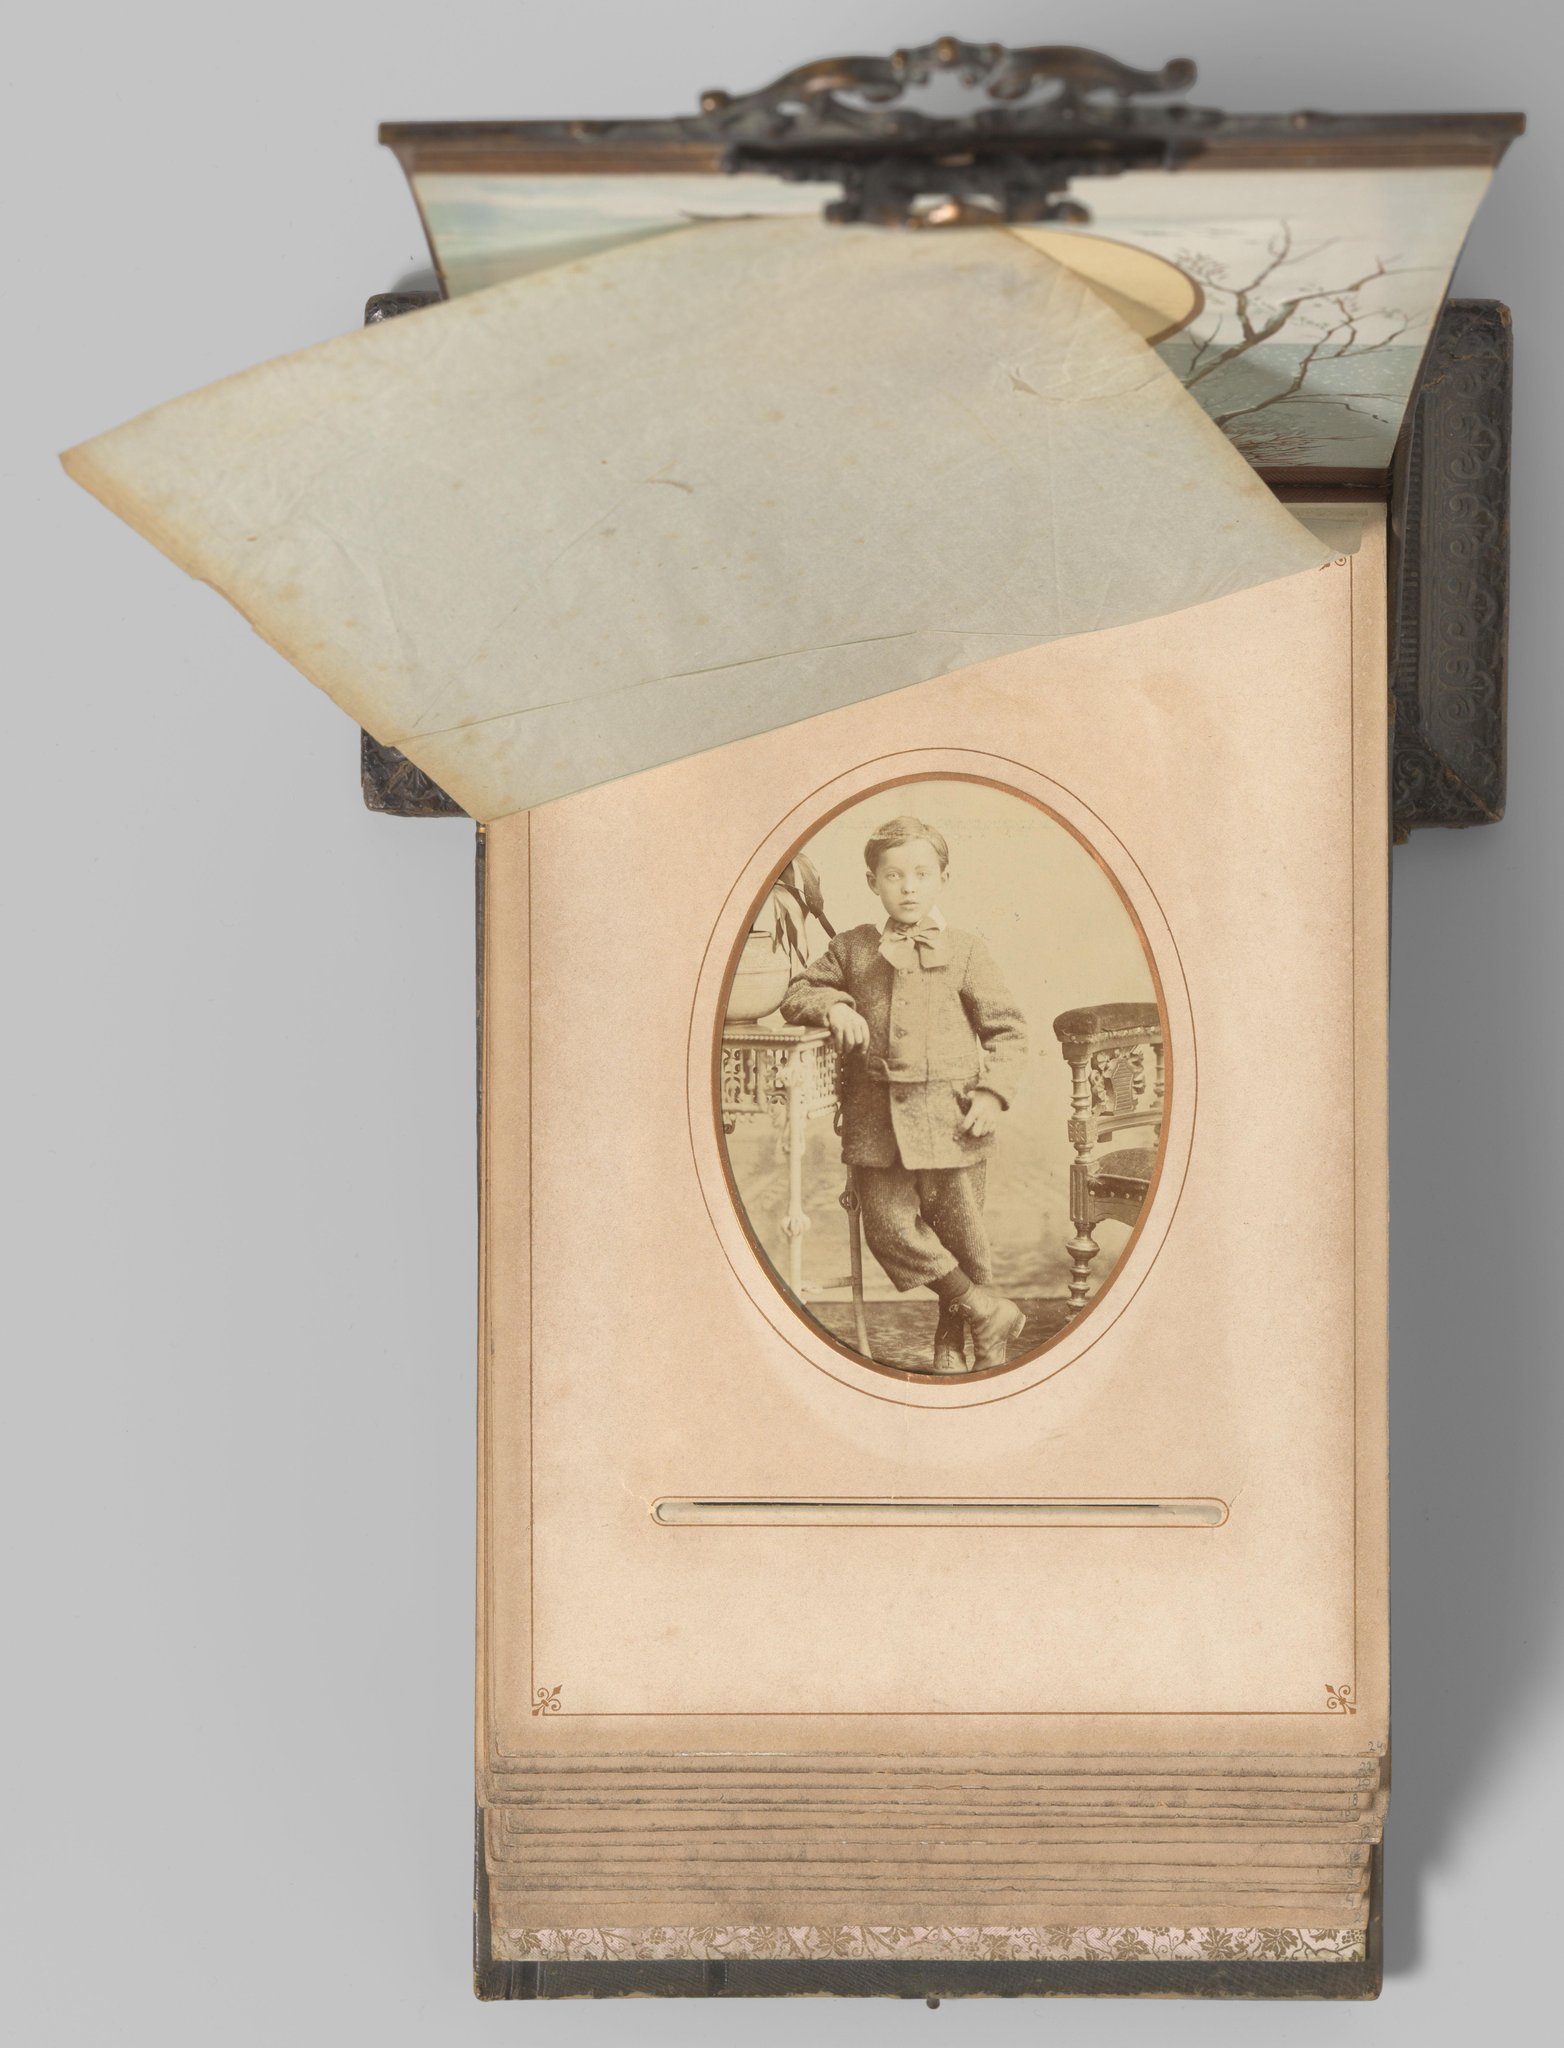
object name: album leaf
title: Portret van een jongen, leunend tegen een tafel met plant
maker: henry thomas edwards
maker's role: fotograaf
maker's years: 1857-1935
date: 1886-1904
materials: cardboard, photographic support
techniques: collodion silver print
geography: brighton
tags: boy (child between toddler and youth), historical persons, table, leaning figure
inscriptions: inscription: ‘H. Edwards/ 11, LEWES Rd/ Brighton.’, number: ‘10317’